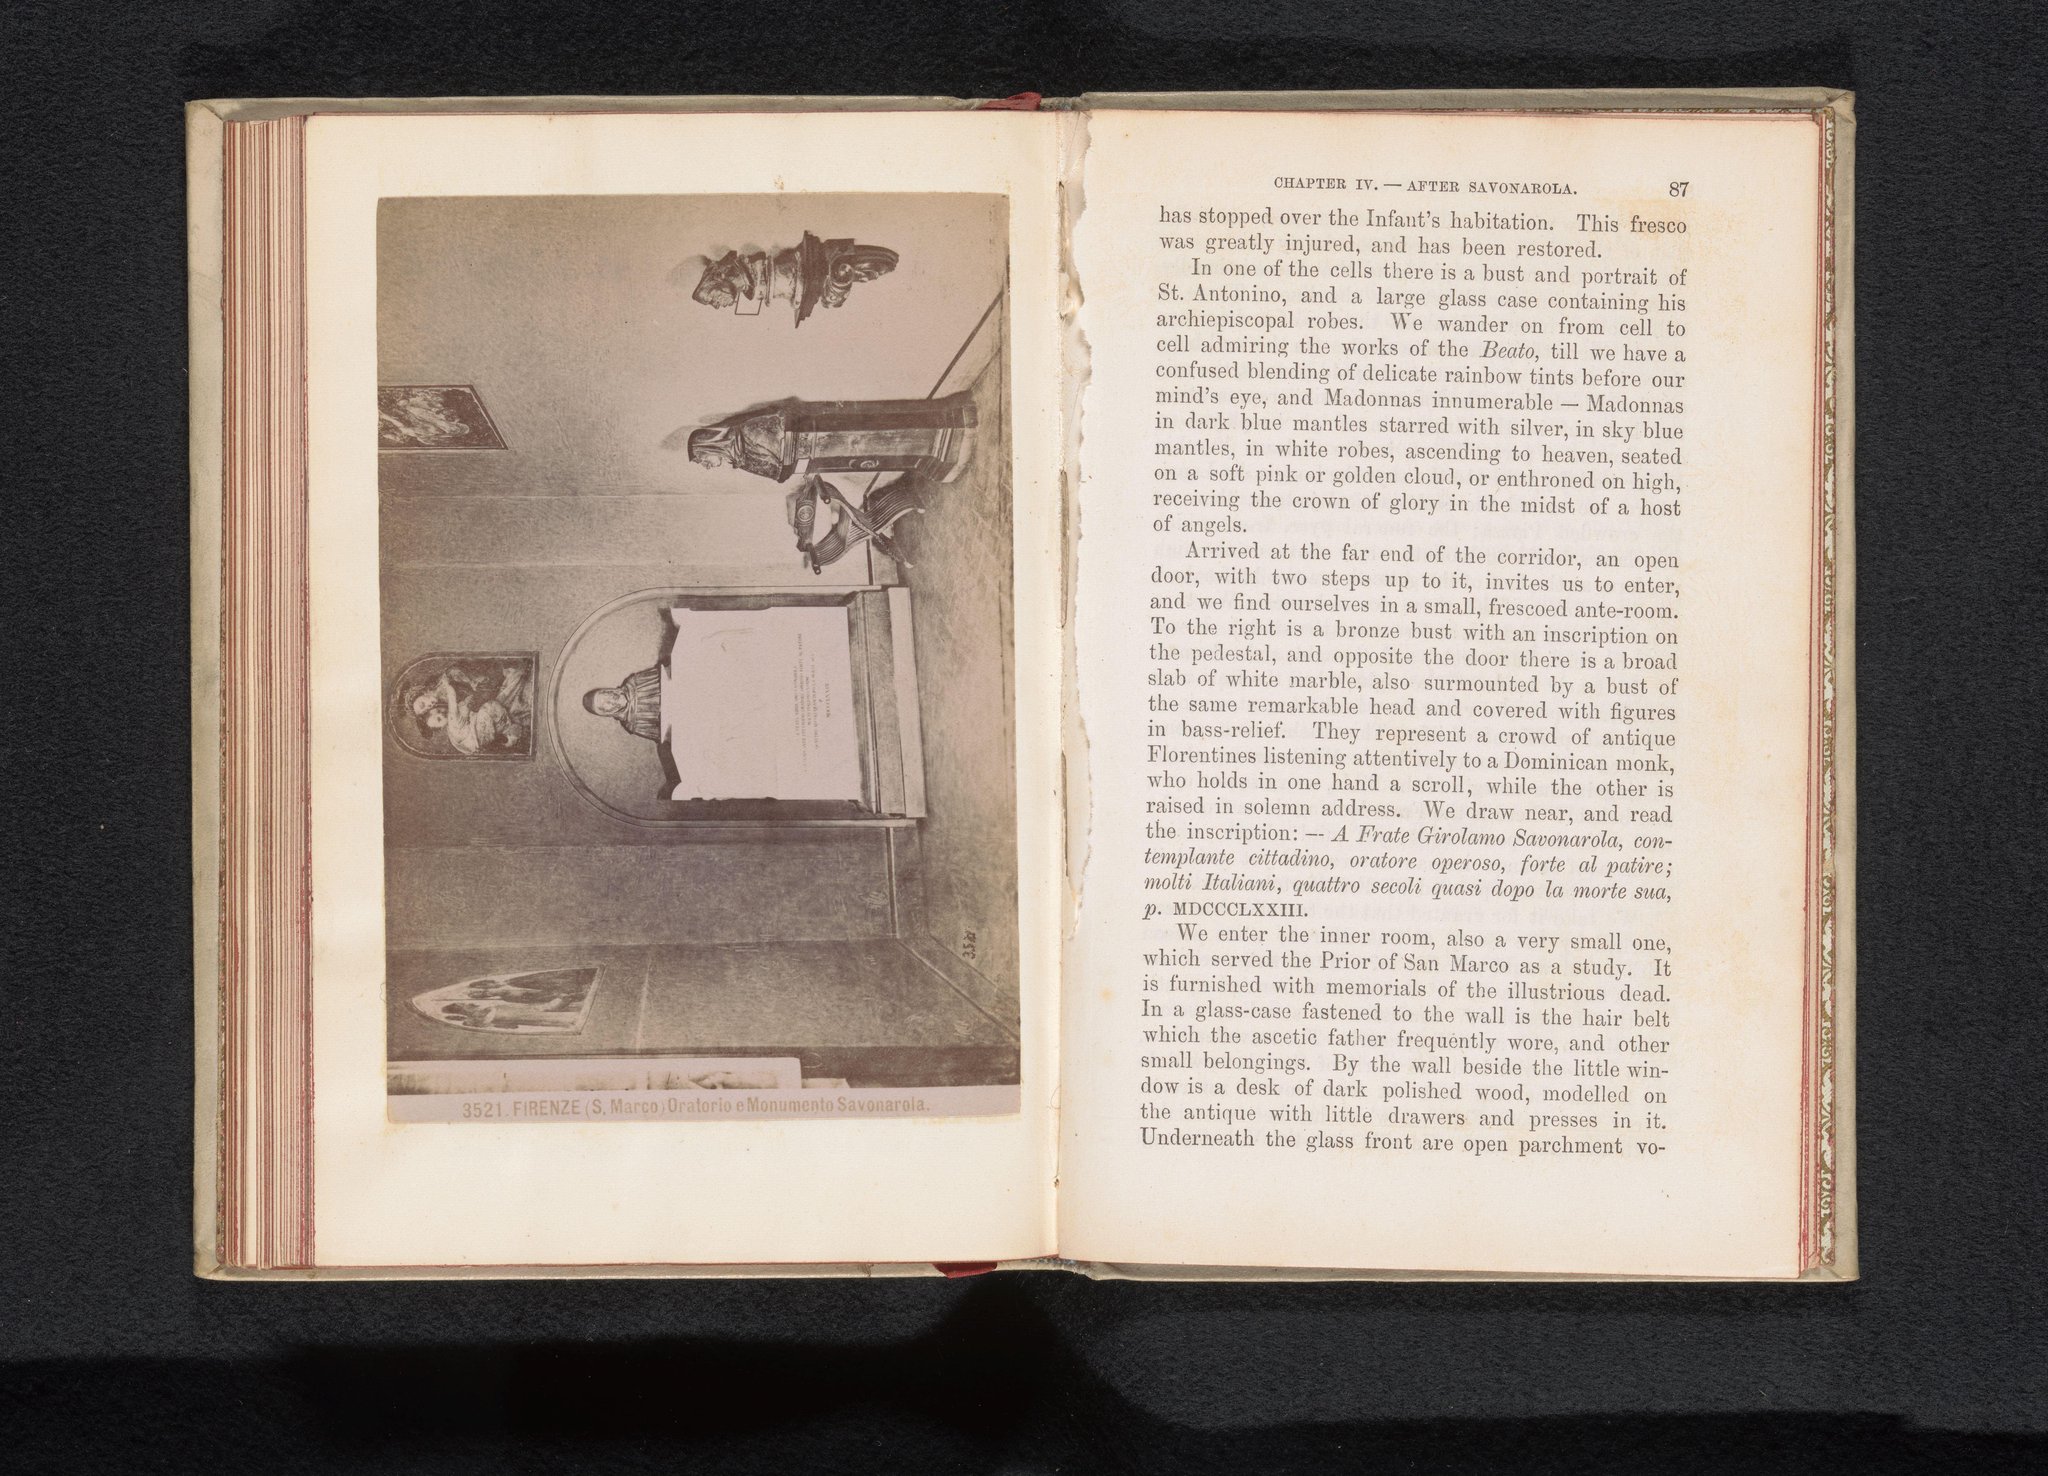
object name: page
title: Oratorium in het San Marco-klooster te Florence met een monument voor Girolamo Savonarola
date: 1878-1888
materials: photographic support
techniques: albumen print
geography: san marco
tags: abbey, monastery, convent ~ roman catholic church, monument, statue, interior ~ representation of a building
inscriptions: number: ‘3521.’